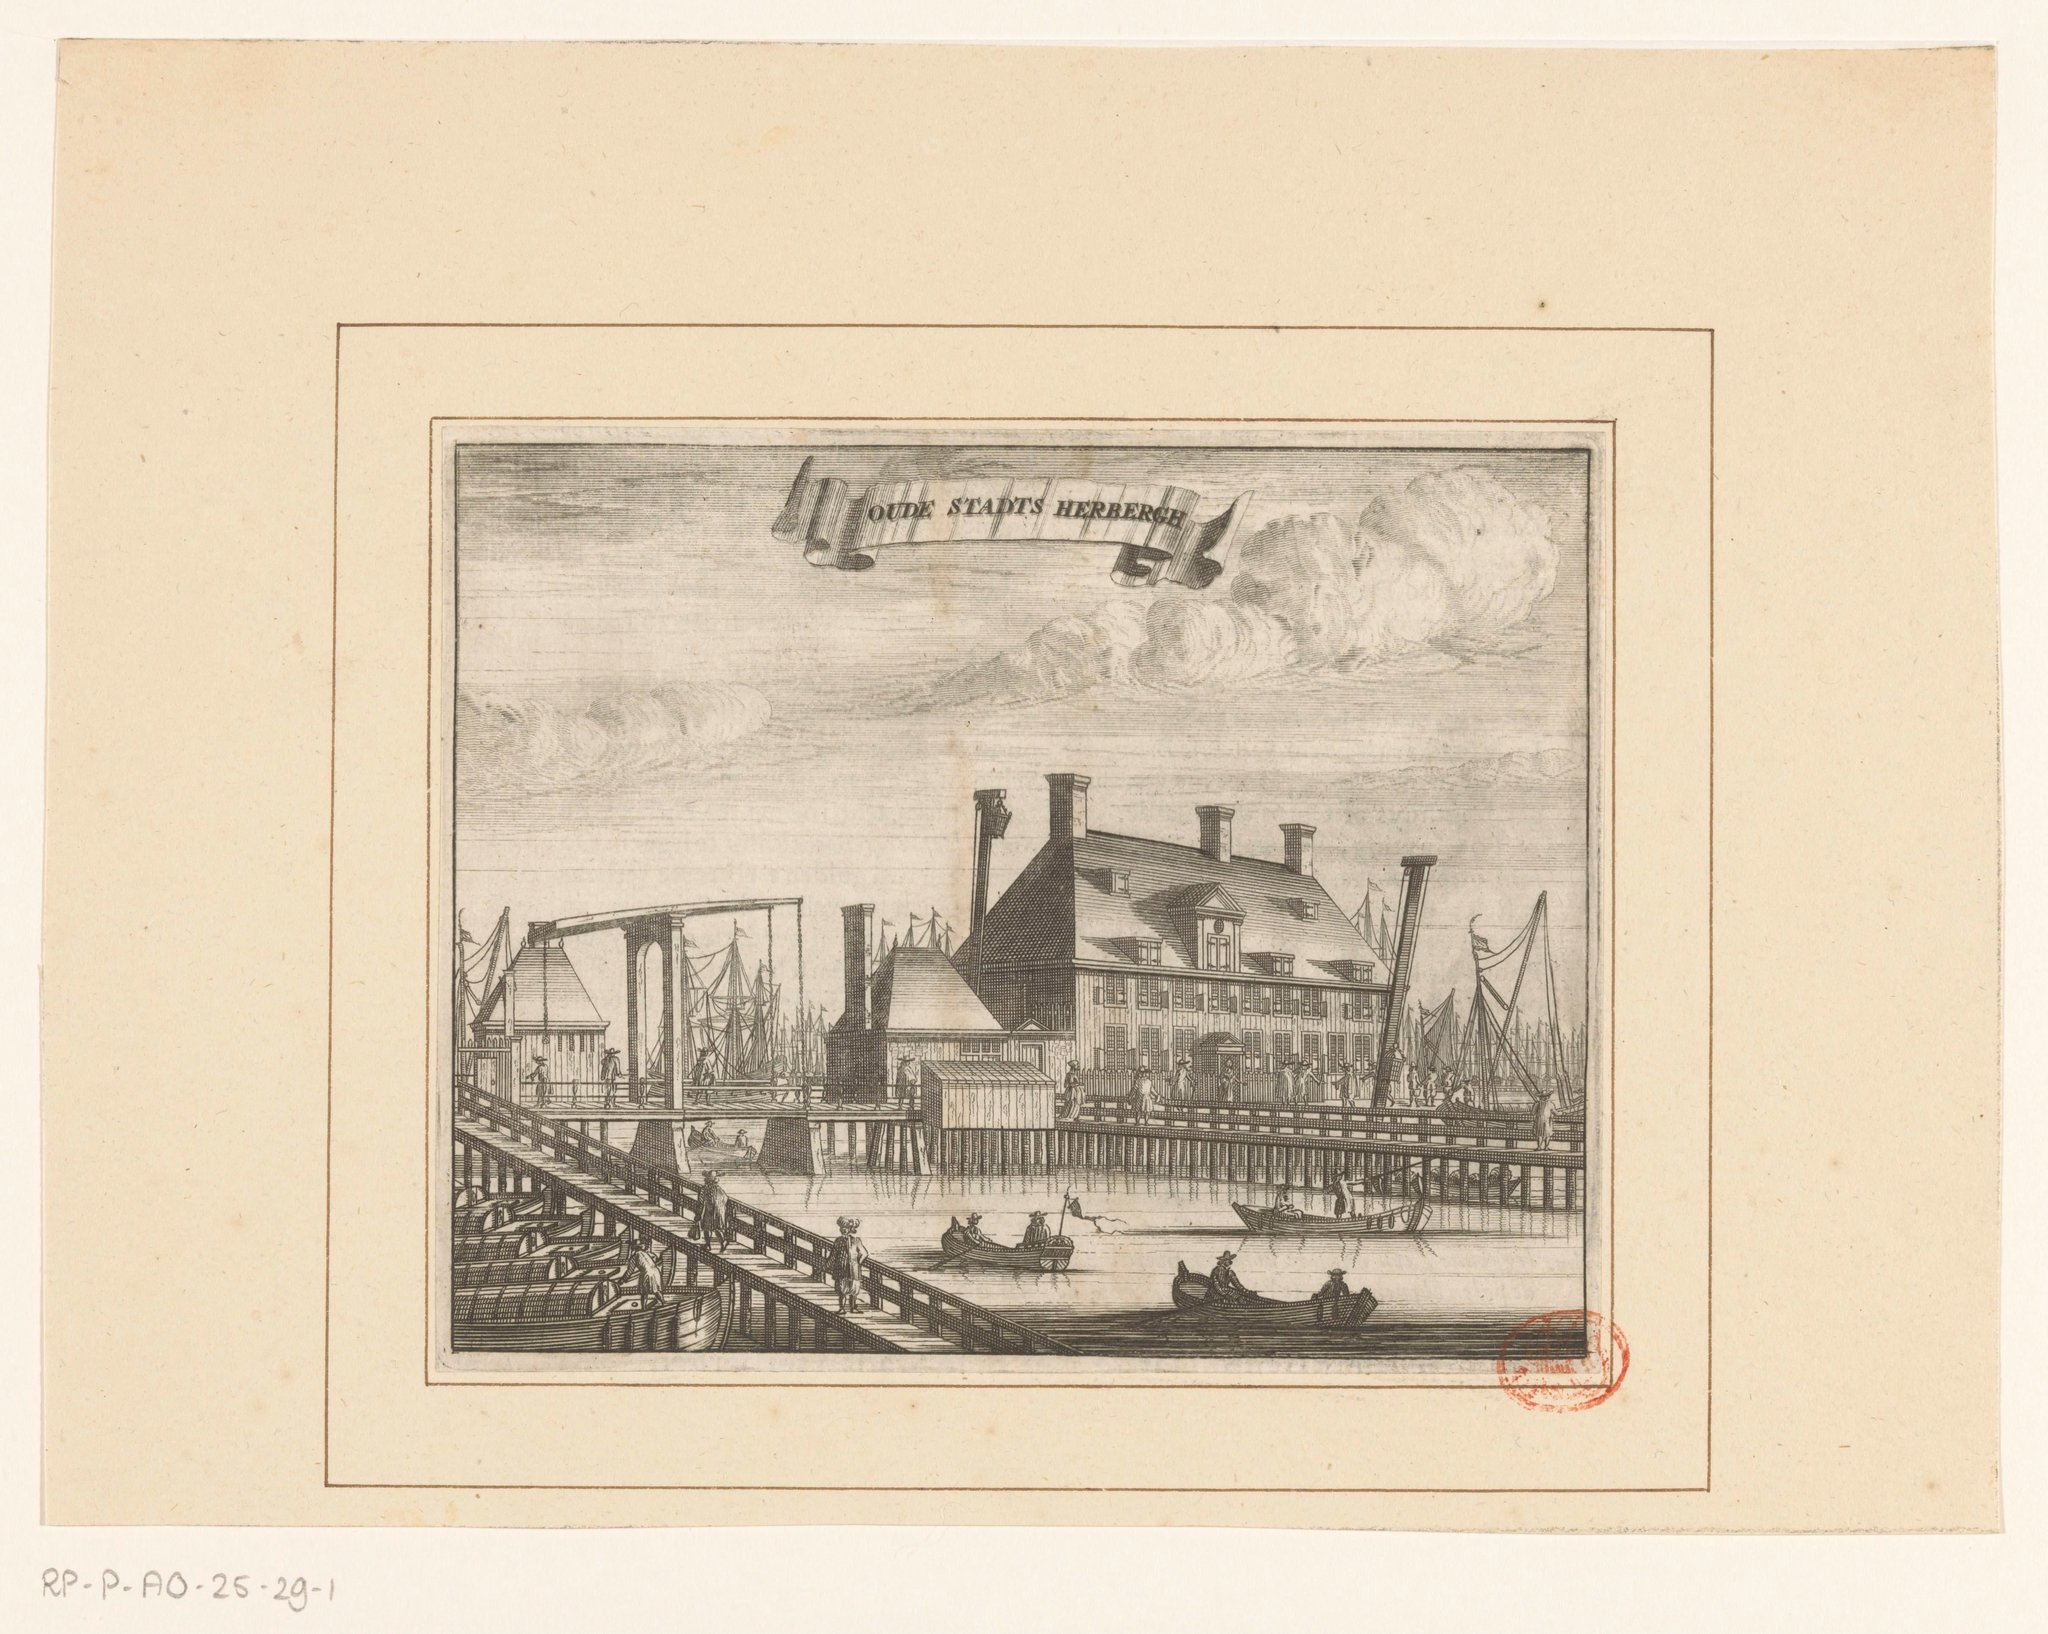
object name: book illustration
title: Oude Stadts Herbergh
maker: Anonymous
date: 1693-1694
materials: paper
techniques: engraving, etching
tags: pier, quay, wharf, hotel, hostelry, inn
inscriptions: collector's mark: Lugt 195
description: Huidige staat van prent ook gebruikt in: Commelin, Caspar. Beschryvinge van Amsterdam, desselfs eerste oorspronk uyt den Huyse (…). 2 delen. Amsterdam: Abraham Wolfgang, Gillis Janssonius van Waesberge, Johannes Janssonius van Waesberge II, weduwe Dirk Boom I, Hendrick Boom en Rembertus Goethals, 1693. En in: Commelin, Caspar. Beschryvinge van Amsterdam, zynde een naukeurige verhandelinge van desselfs eerste oorspronk uyt (…). 2 delen. Amsterdam: weduwe Aart Dircksz Oossaan, 1694. Latere staat ook gebruikt in: Commelin, Caspar. Beschryvinge van Amsterdam, zynde een naukeurige verhandelinge van desselfs eerste oorspronk uyt (…). 2 delen. 2e druk. Amsterdam: Andries van Damme, Johannes Ratelband, weduwe A. van Aaltwyk en Hermanus Uytwerf, 1726.